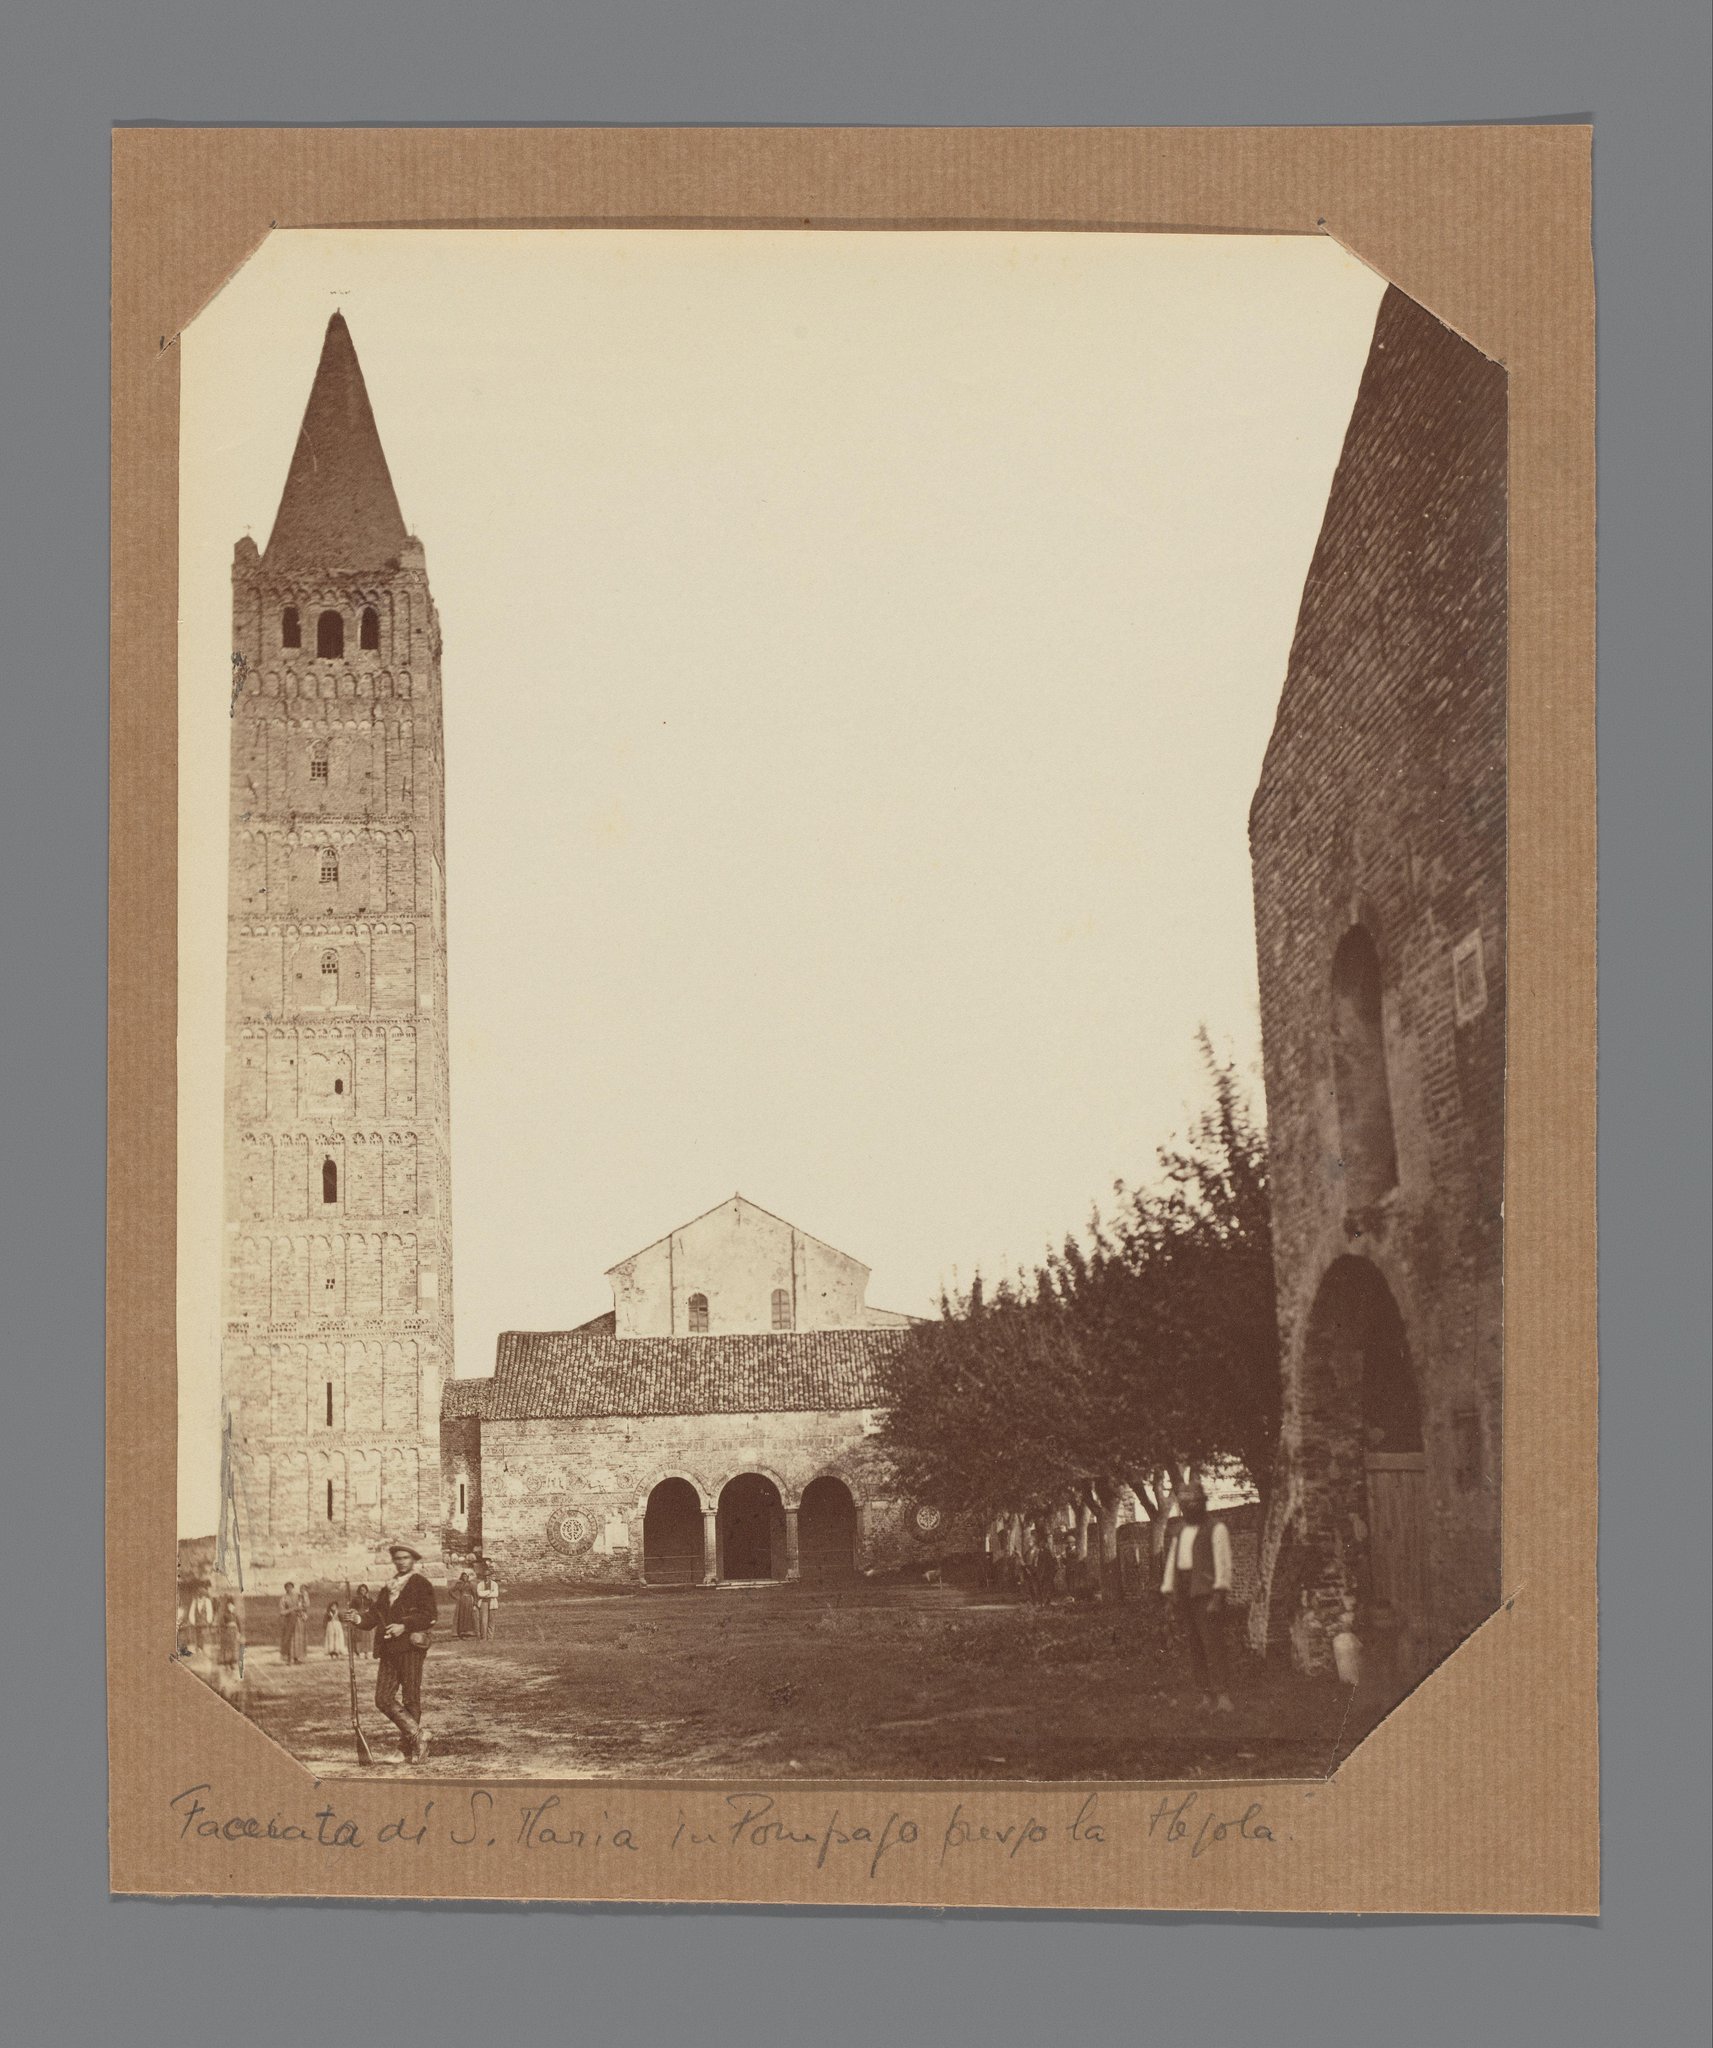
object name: photograph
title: Italië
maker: Anonymous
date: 1880-1910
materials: photographic support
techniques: albumen print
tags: italy